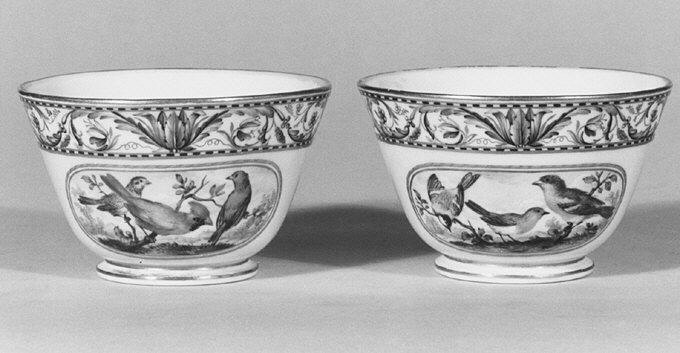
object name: saucer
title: Saucer (part of a service)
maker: meissen manufactory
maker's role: manufactory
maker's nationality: german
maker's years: 1710-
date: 1780-1785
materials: hard paste porcelain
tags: birds